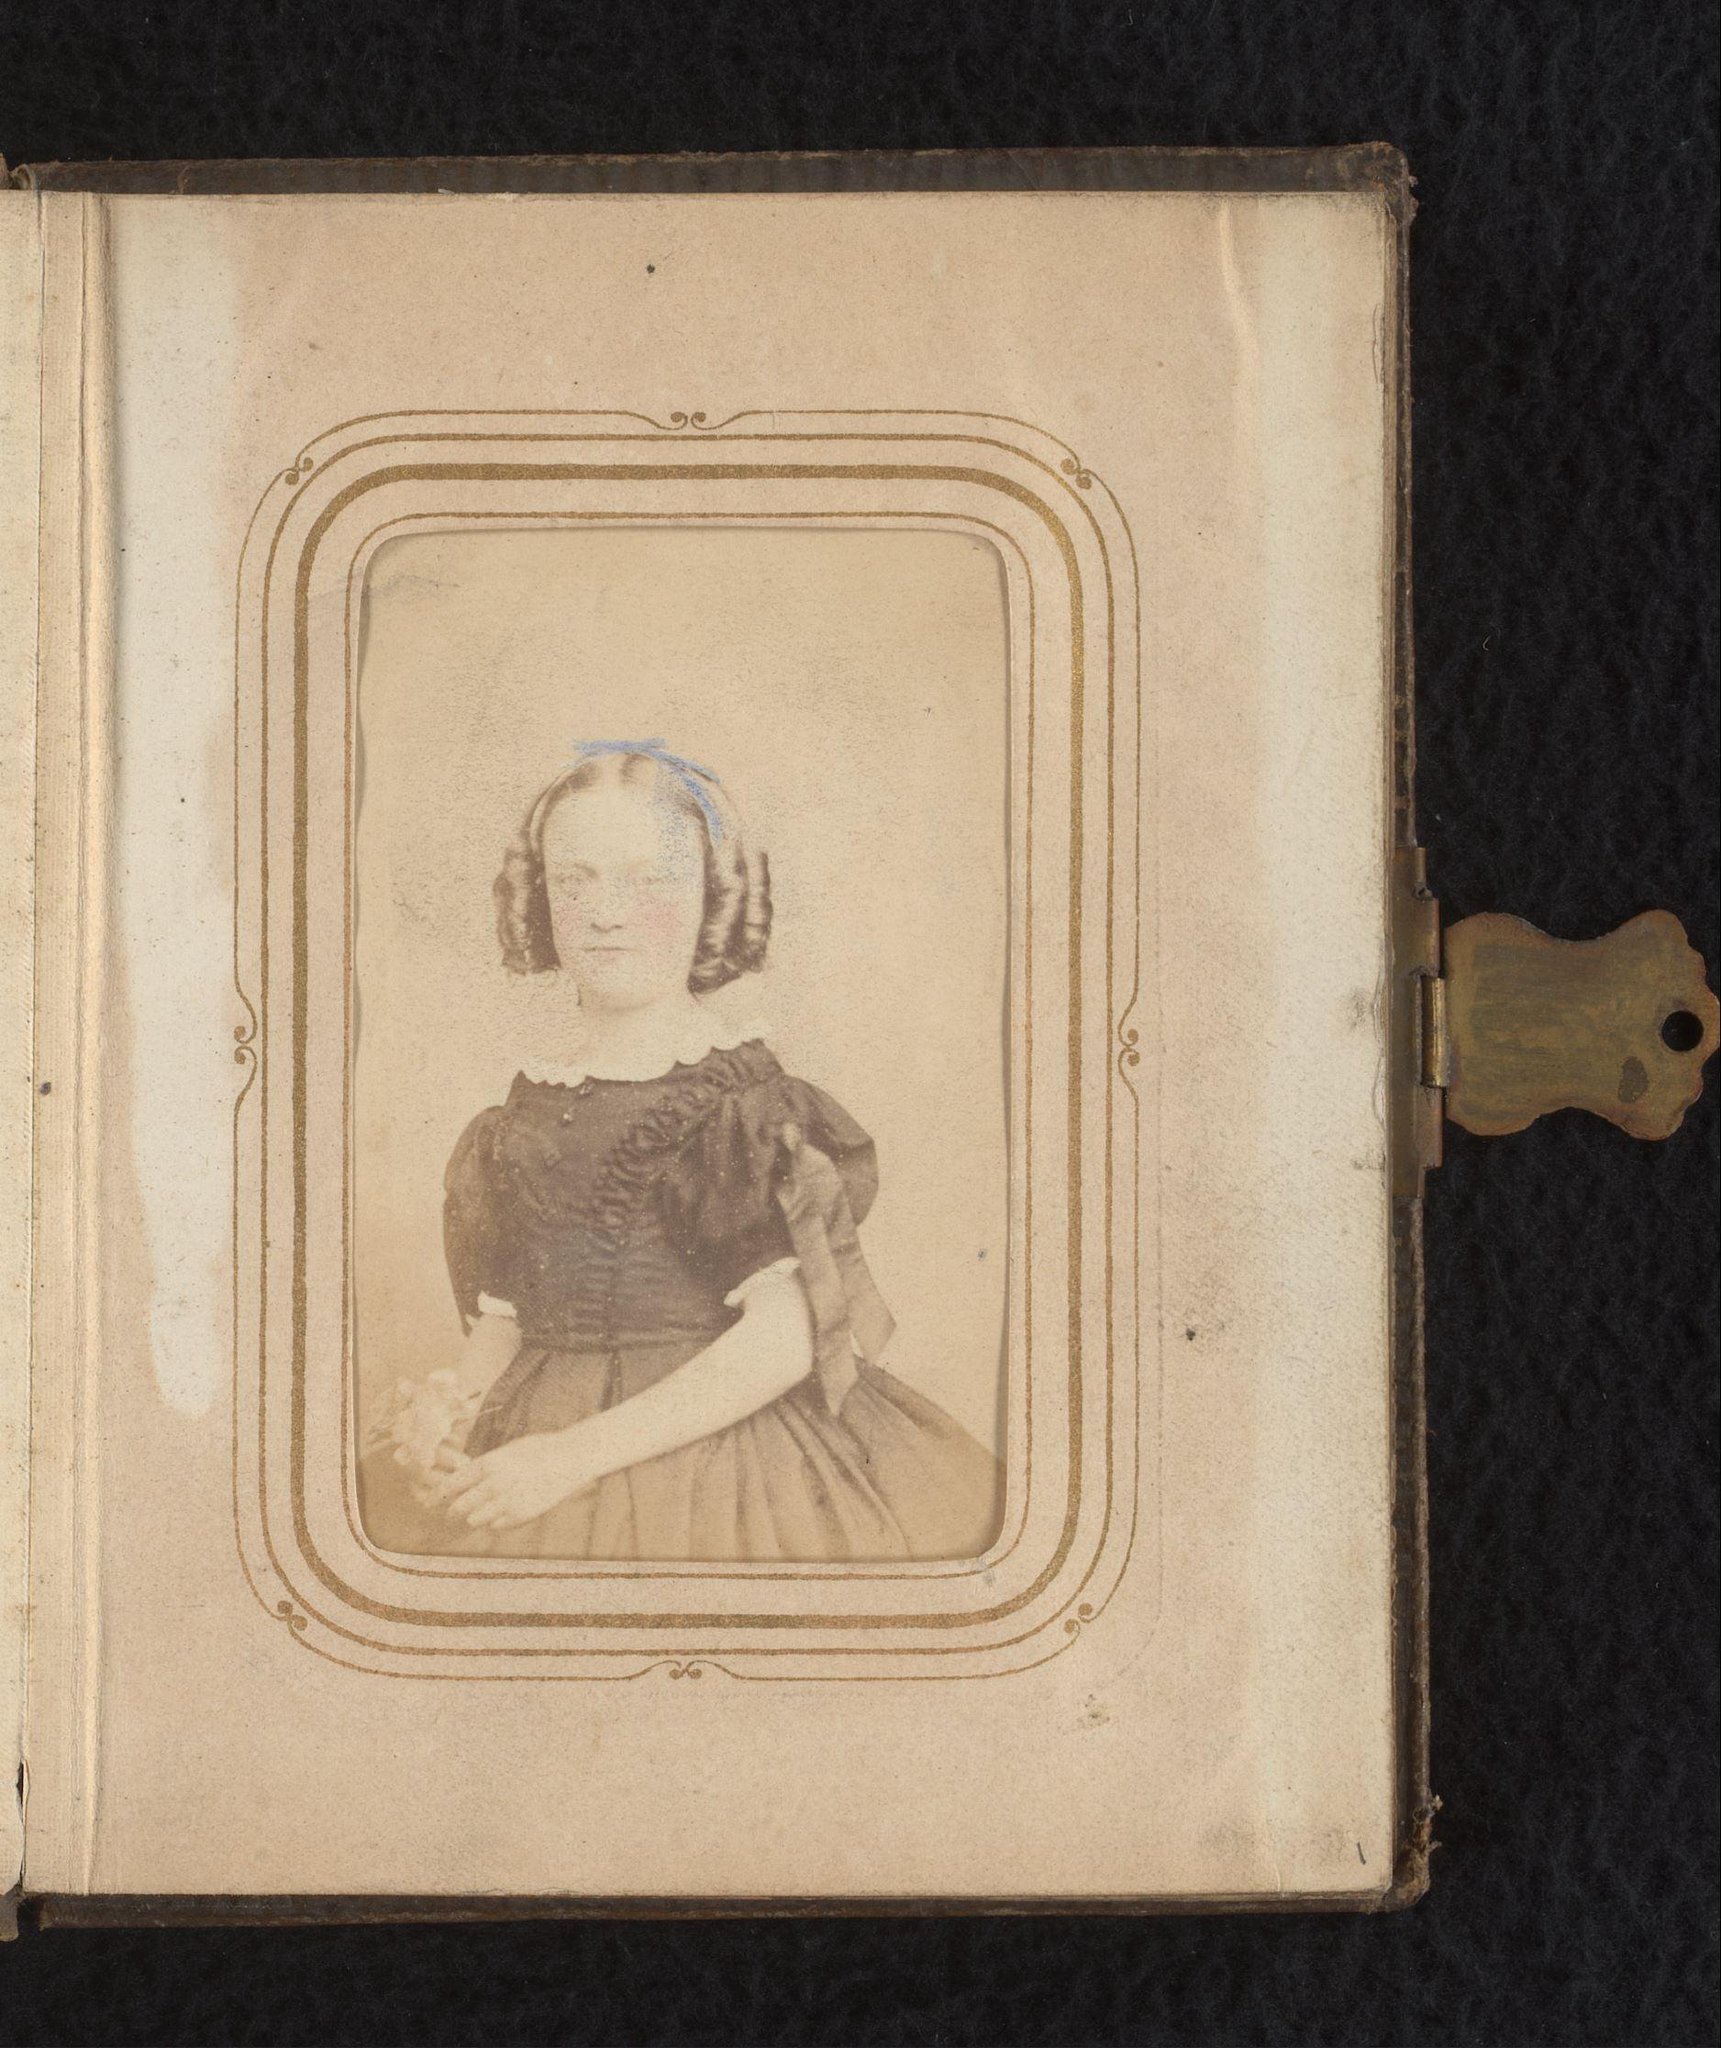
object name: album leaf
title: Portret van een meisje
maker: r. griffiths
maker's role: fotograaf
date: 1860-1900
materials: cardboard, photographic support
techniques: albumen print, hand coloring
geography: truro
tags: girl (child between toddler and youth)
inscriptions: inscription: ‘Photographed by/ Mr. R. Griffiths/ Truro/ Artist/ Under Government’